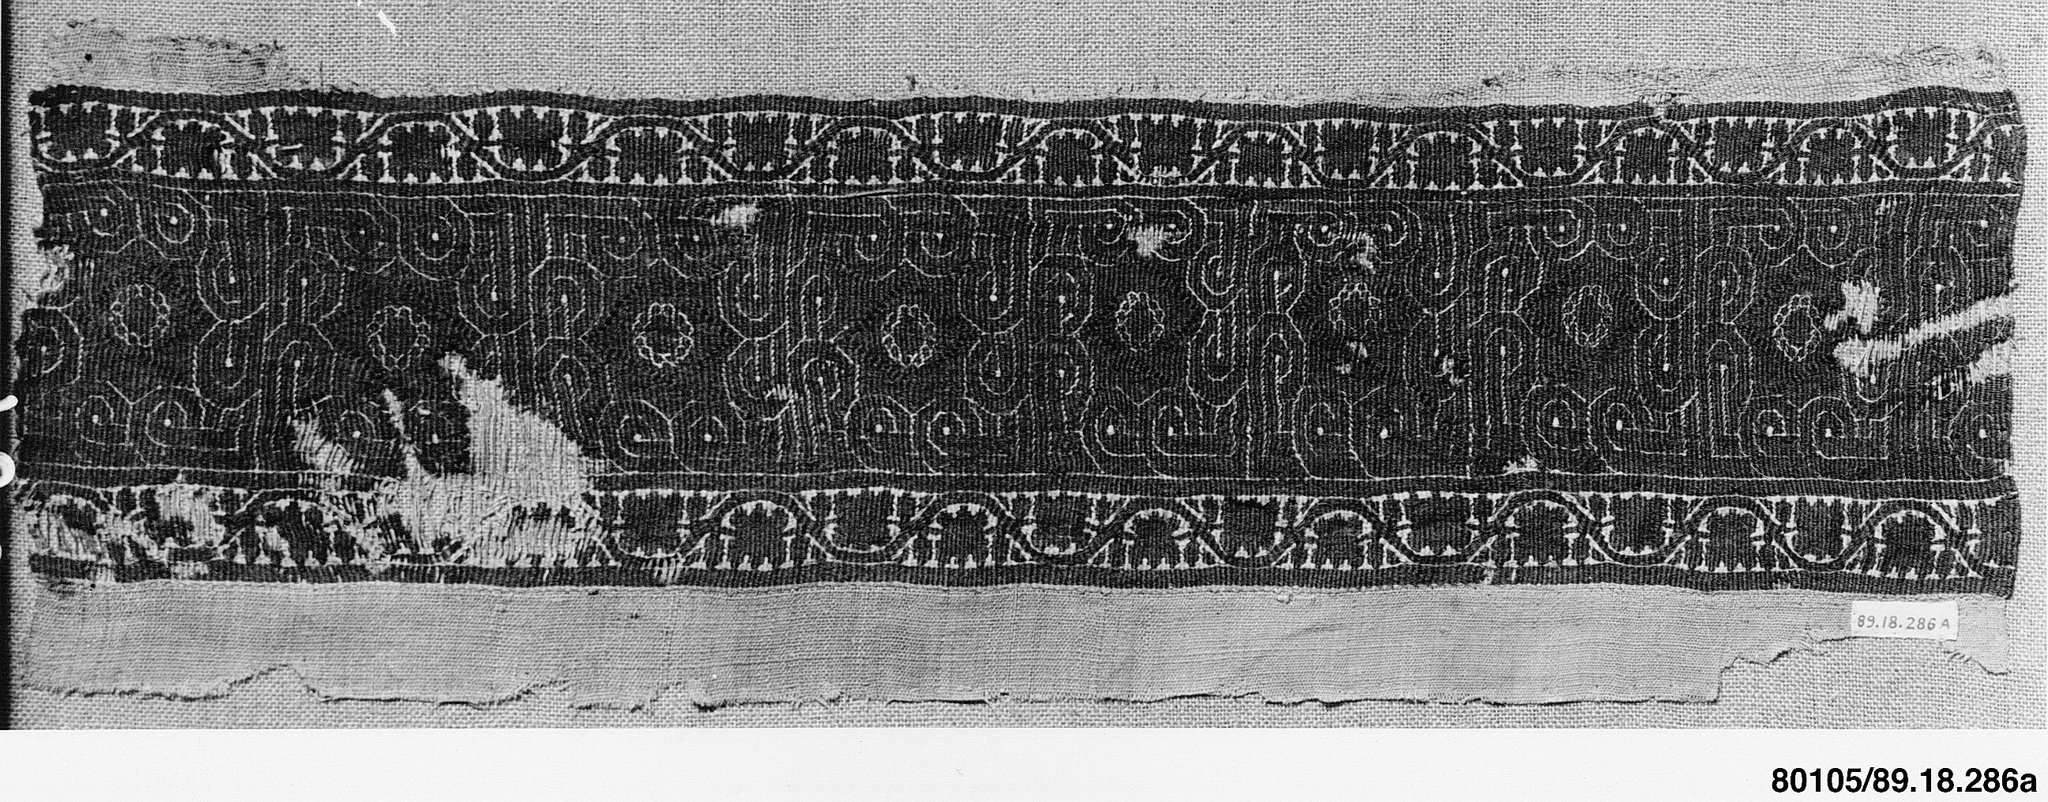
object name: textile fragment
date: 201-400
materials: linen, wool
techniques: weave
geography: egypt